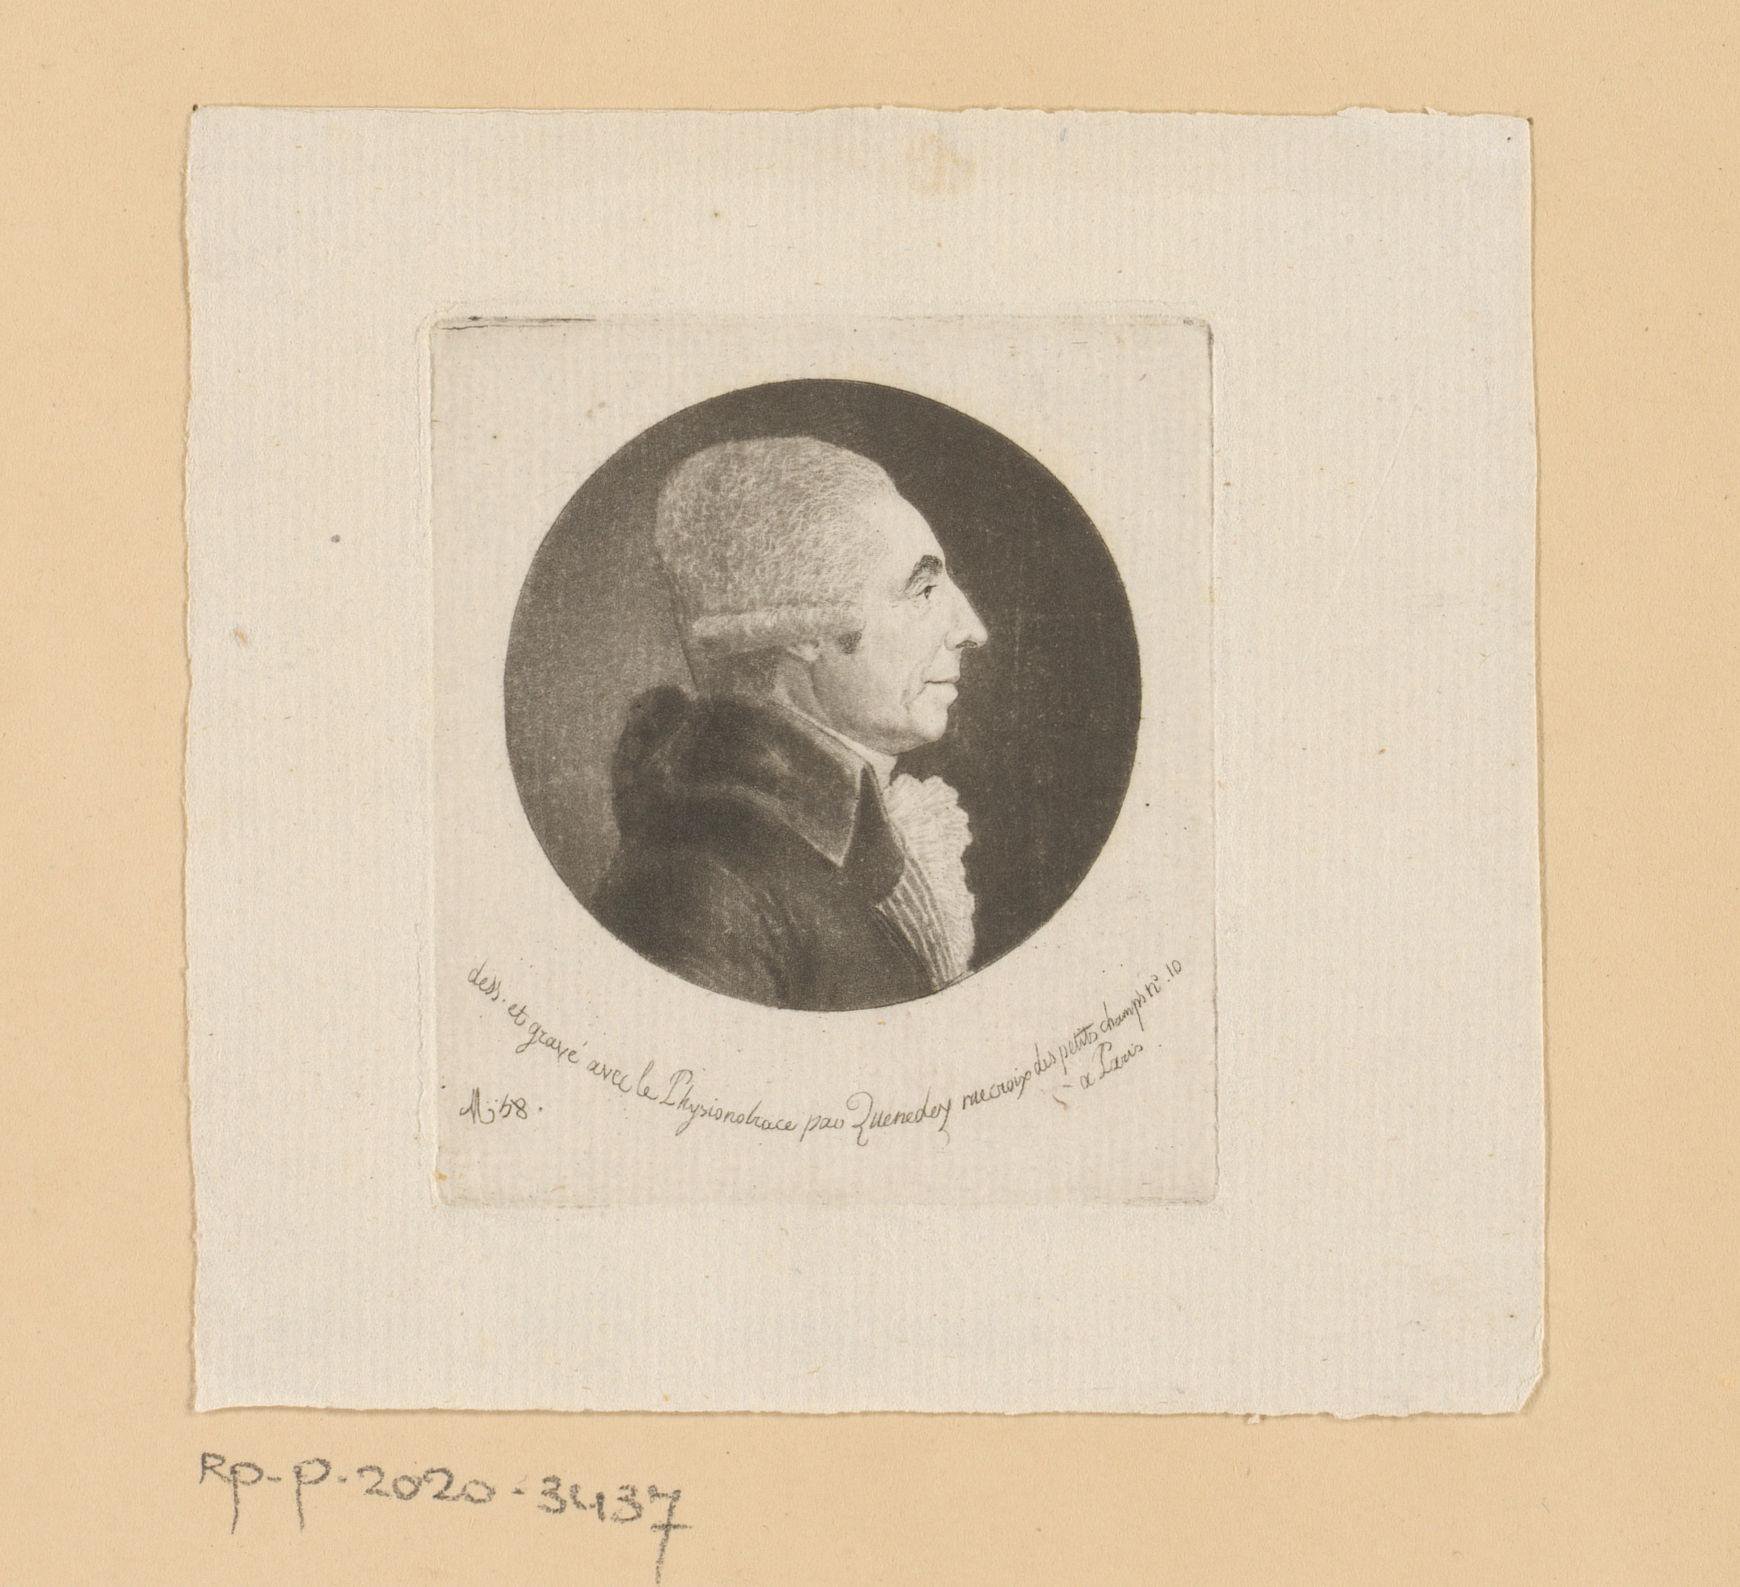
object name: physionotrace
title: Portret van Matthias Temminck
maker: edme quenedey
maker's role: print maker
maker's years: 1756-1830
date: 1785-1814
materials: paper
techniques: aquatint, etching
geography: paris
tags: silhouette-apparatus, 'physionotrace', historical persons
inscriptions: collector's mark: Lugt 240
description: Deze prent heeft het nummer M.58 in het fonds van Quenedey.